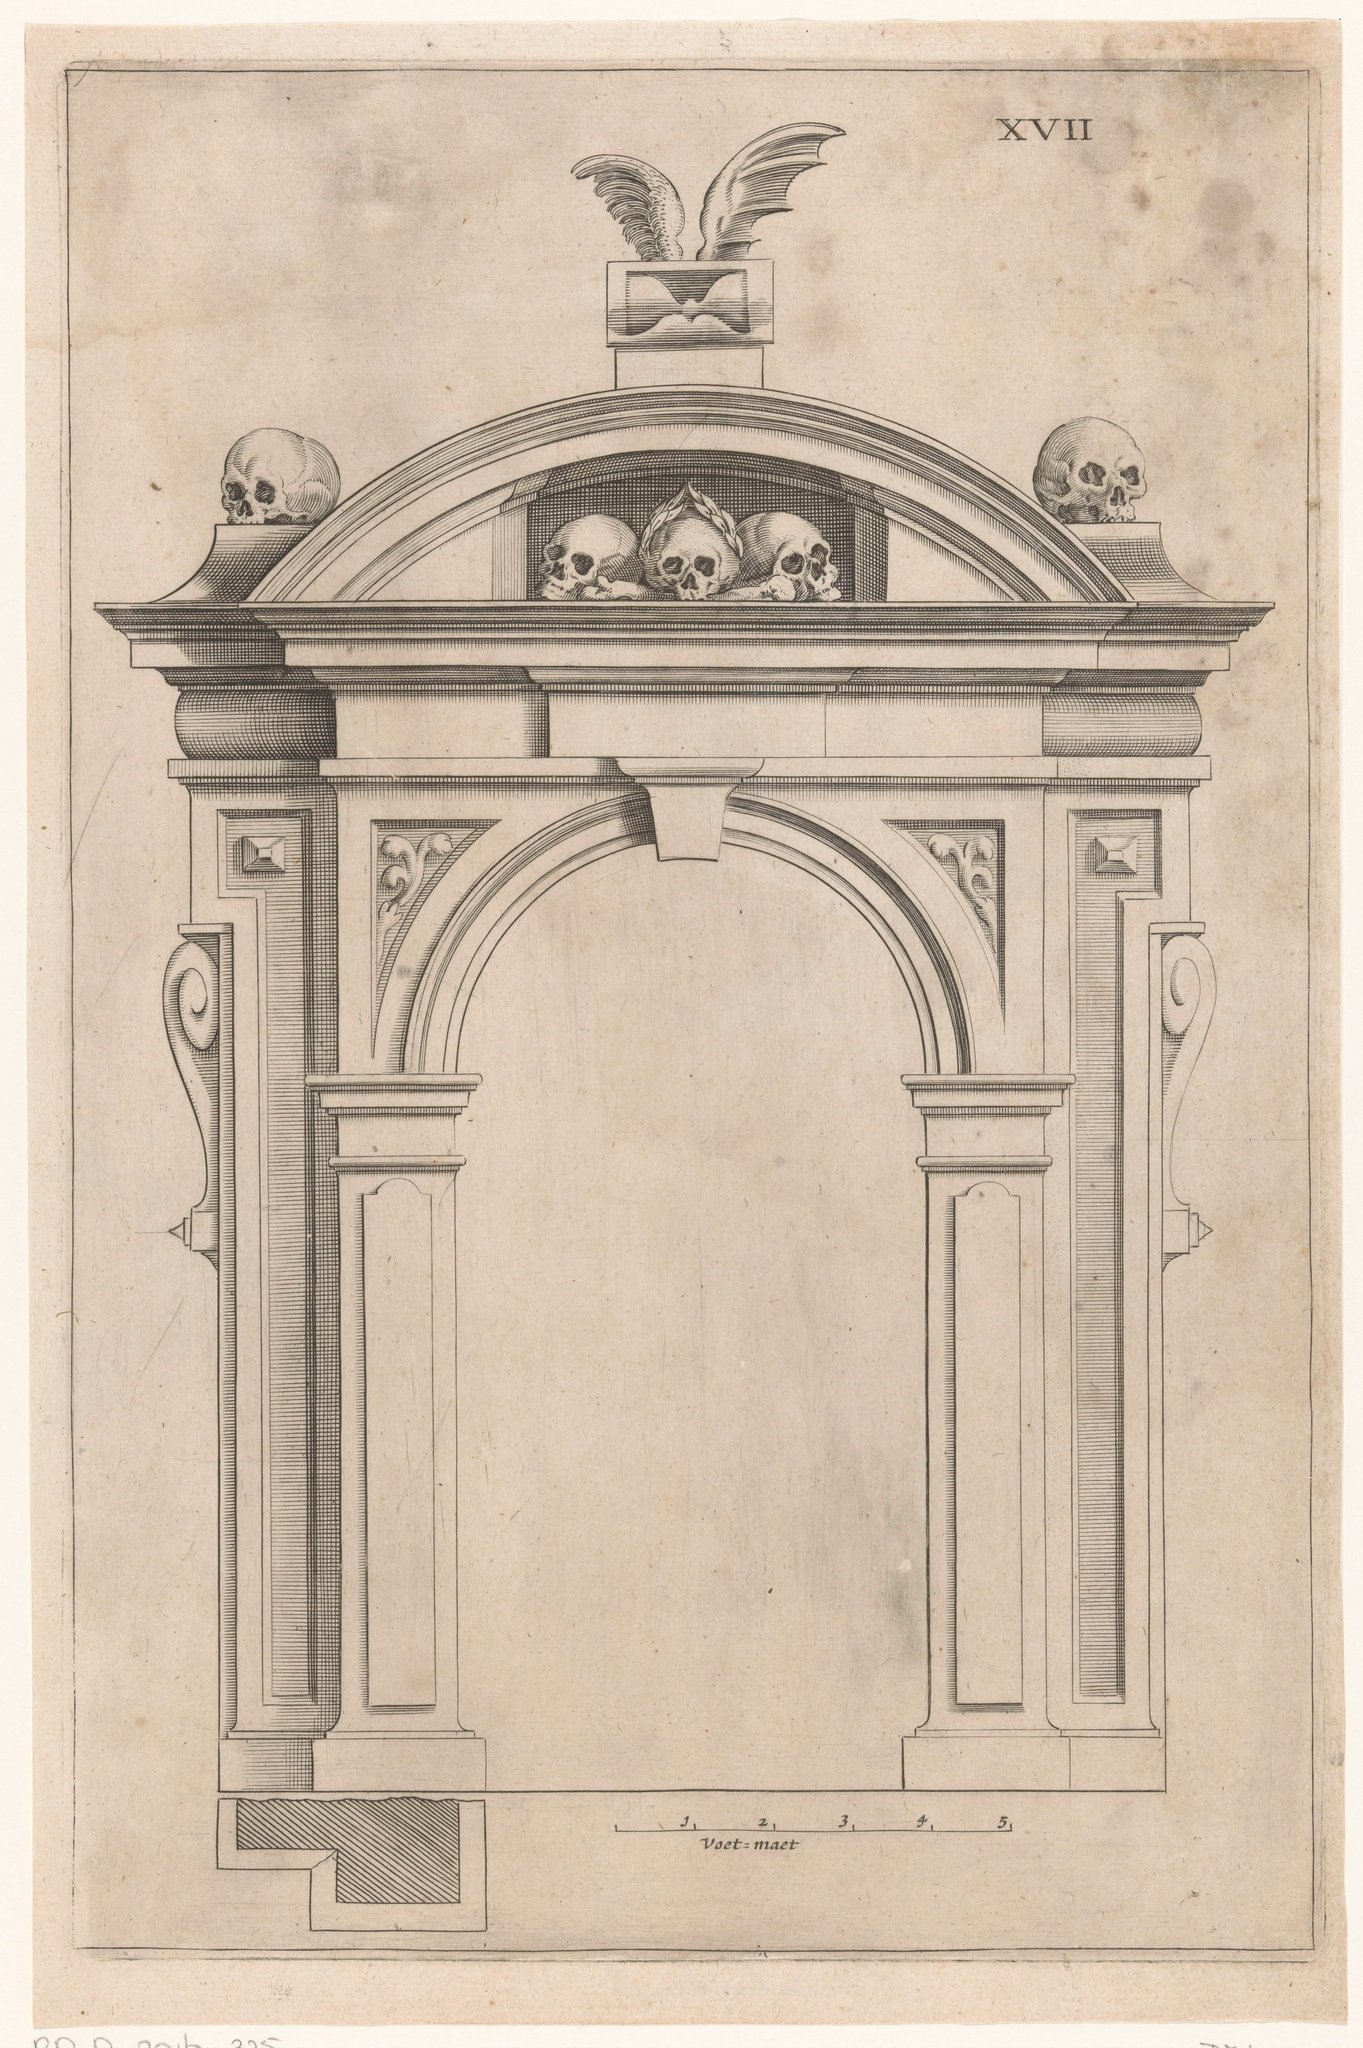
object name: ornament print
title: Poort van de Westerkerk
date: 1631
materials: paper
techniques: engraving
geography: amsterdam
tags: parts of church exterior and annexes: porch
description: Prent uit: Keyser, Hendrick de. Architectura moderna ofte bouwinge van onsen tyt (...) alle gedaen by (...) Amsterdam: Danckerts, Cornelis, 1631.